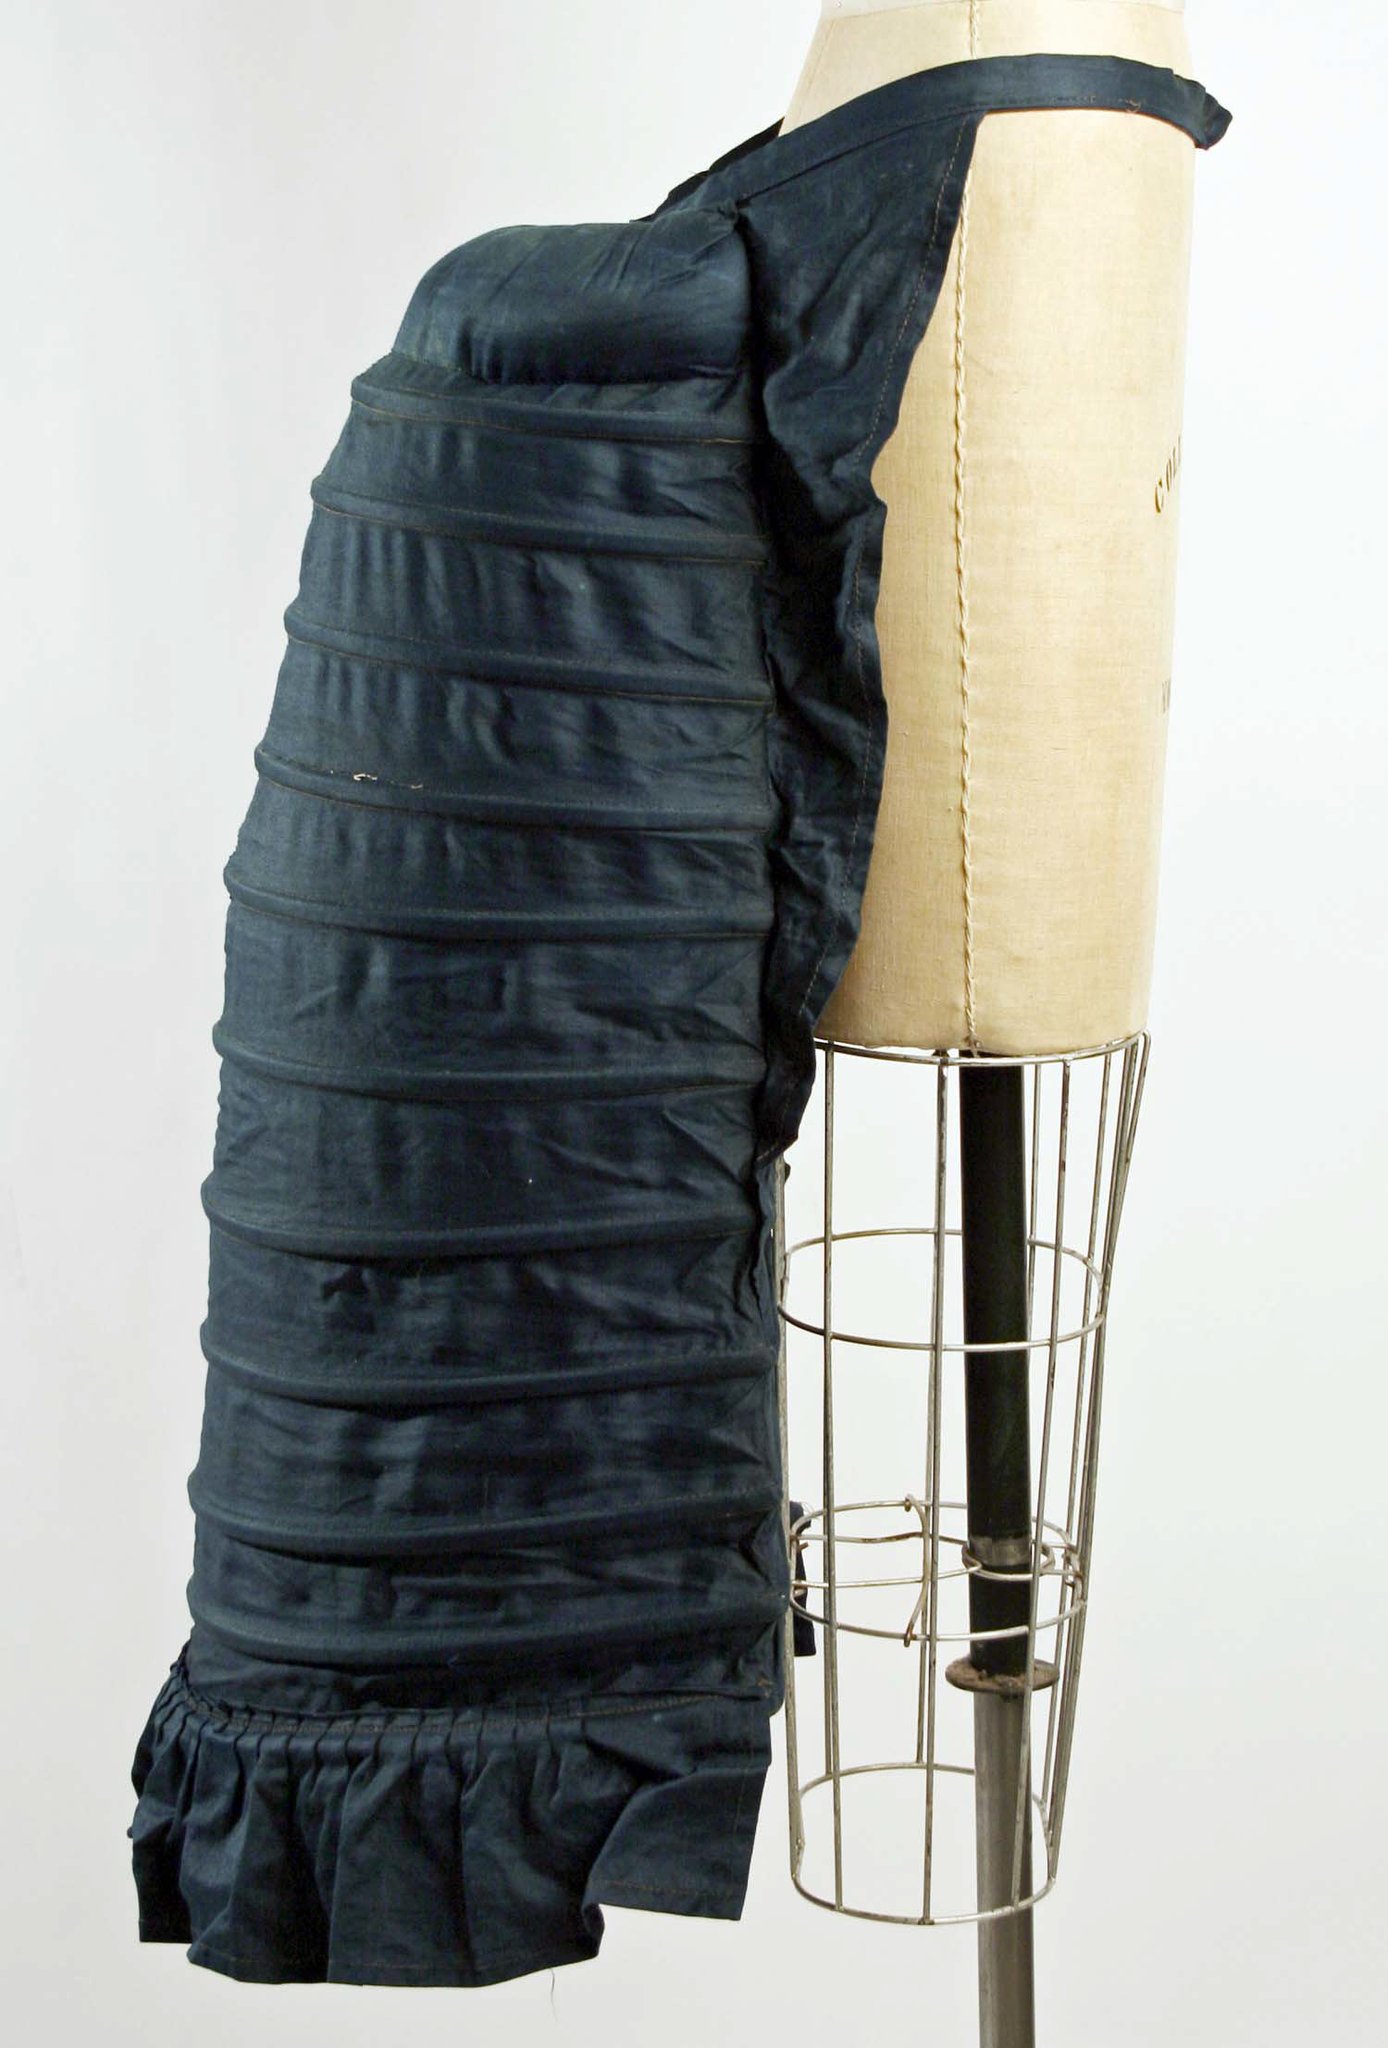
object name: bustle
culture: british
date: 1883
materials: cotton, metal